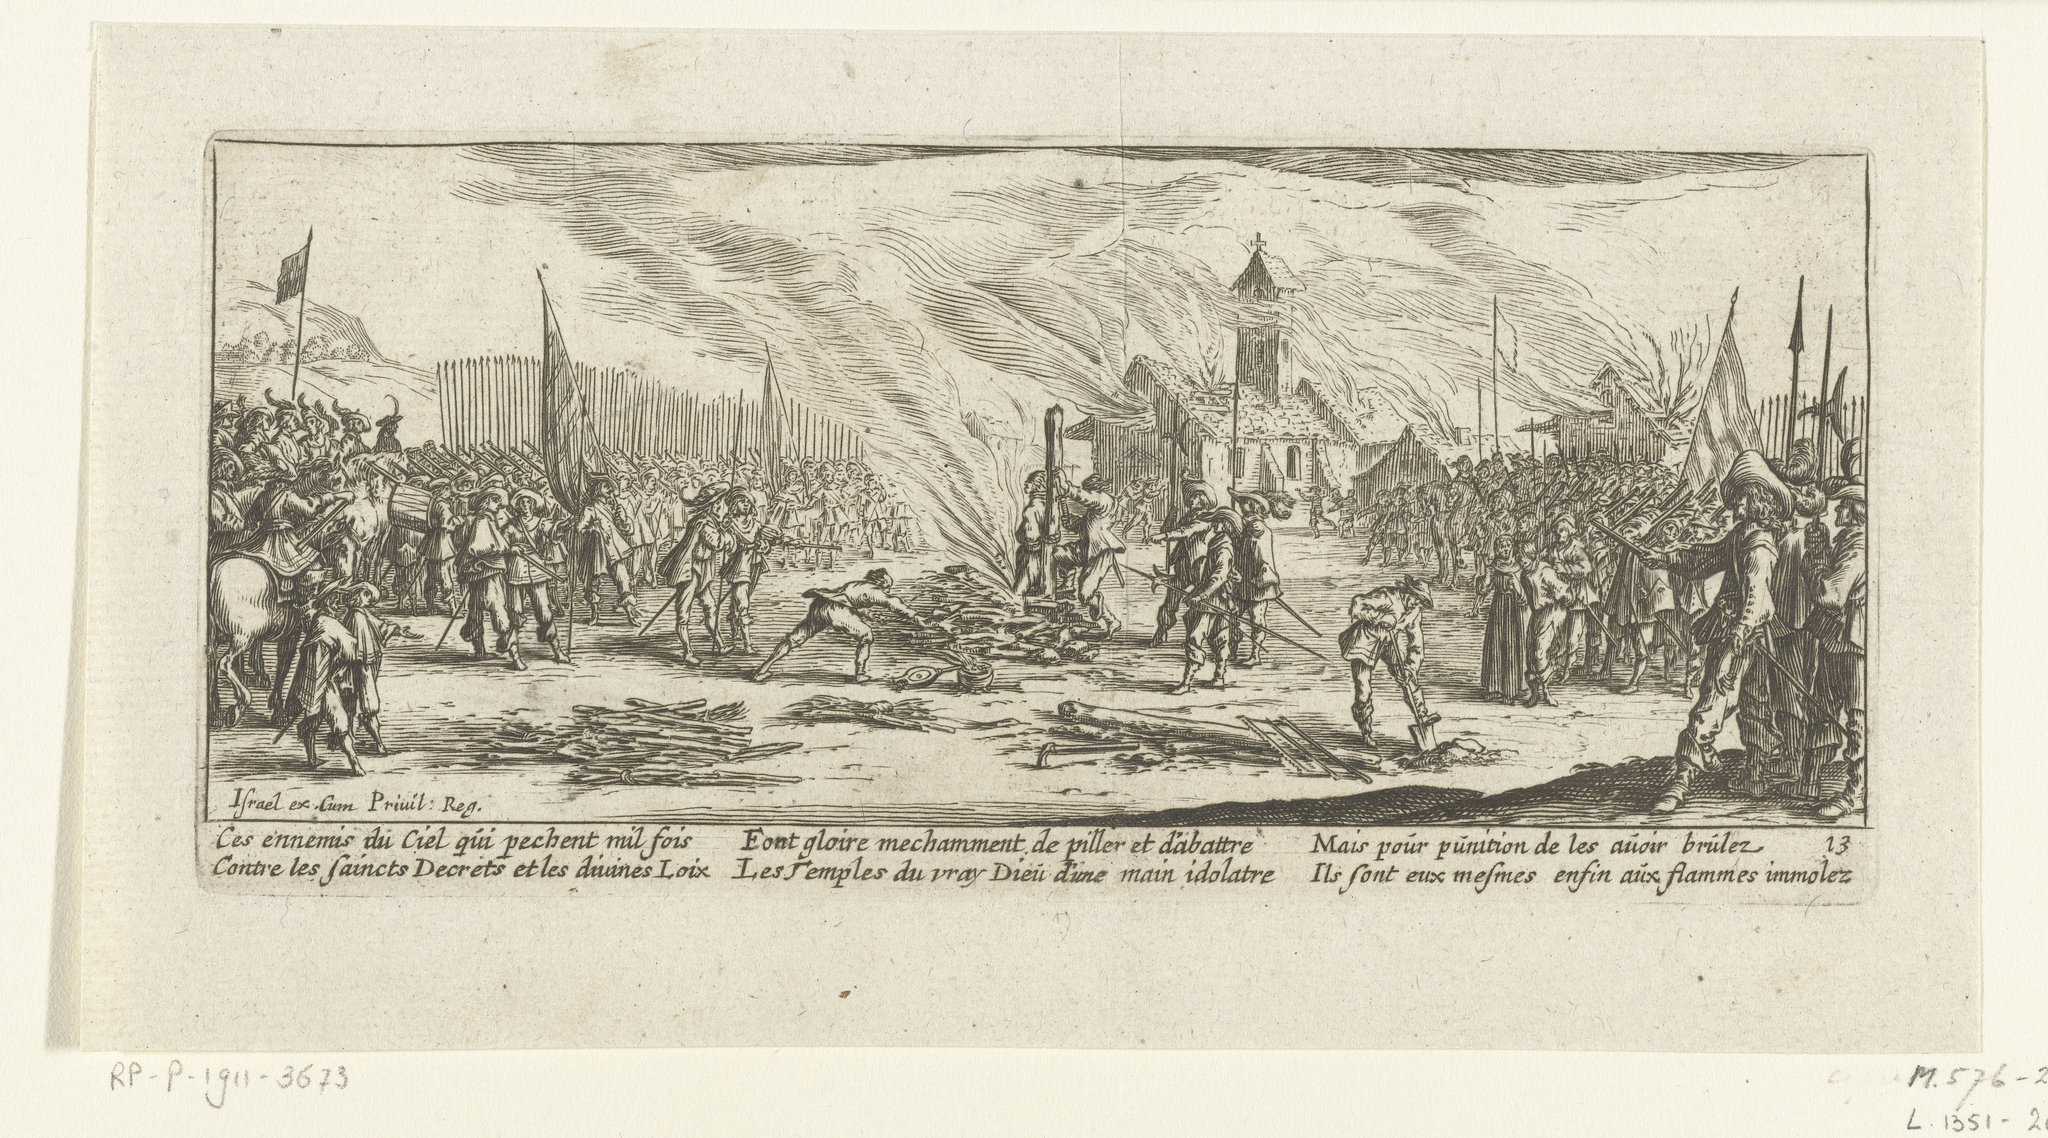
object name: print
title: De droeve ellendigheden van de Oorloogh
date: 1677-1690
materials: paper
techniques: etching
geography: paris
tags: church (exterior), violent death by burning at the stake; pyre, execution ~ military disciplinary punishment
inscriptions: collector's mark: Lugt 2228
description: Op een open plek bij een kerk en enkele huizen die in brand staan, kijken vele soldaten toe hoe een man, aan een paal gebonden, op een brandstapel sterft. Onder de voorstelling een zesregelig Frans vers. Deze prent is onderdeel van een serie van 17 (18 incl. titelprent) prenten met voorstellingen van diverse soorten ellende die oorlogvoering met zich meebrengt.